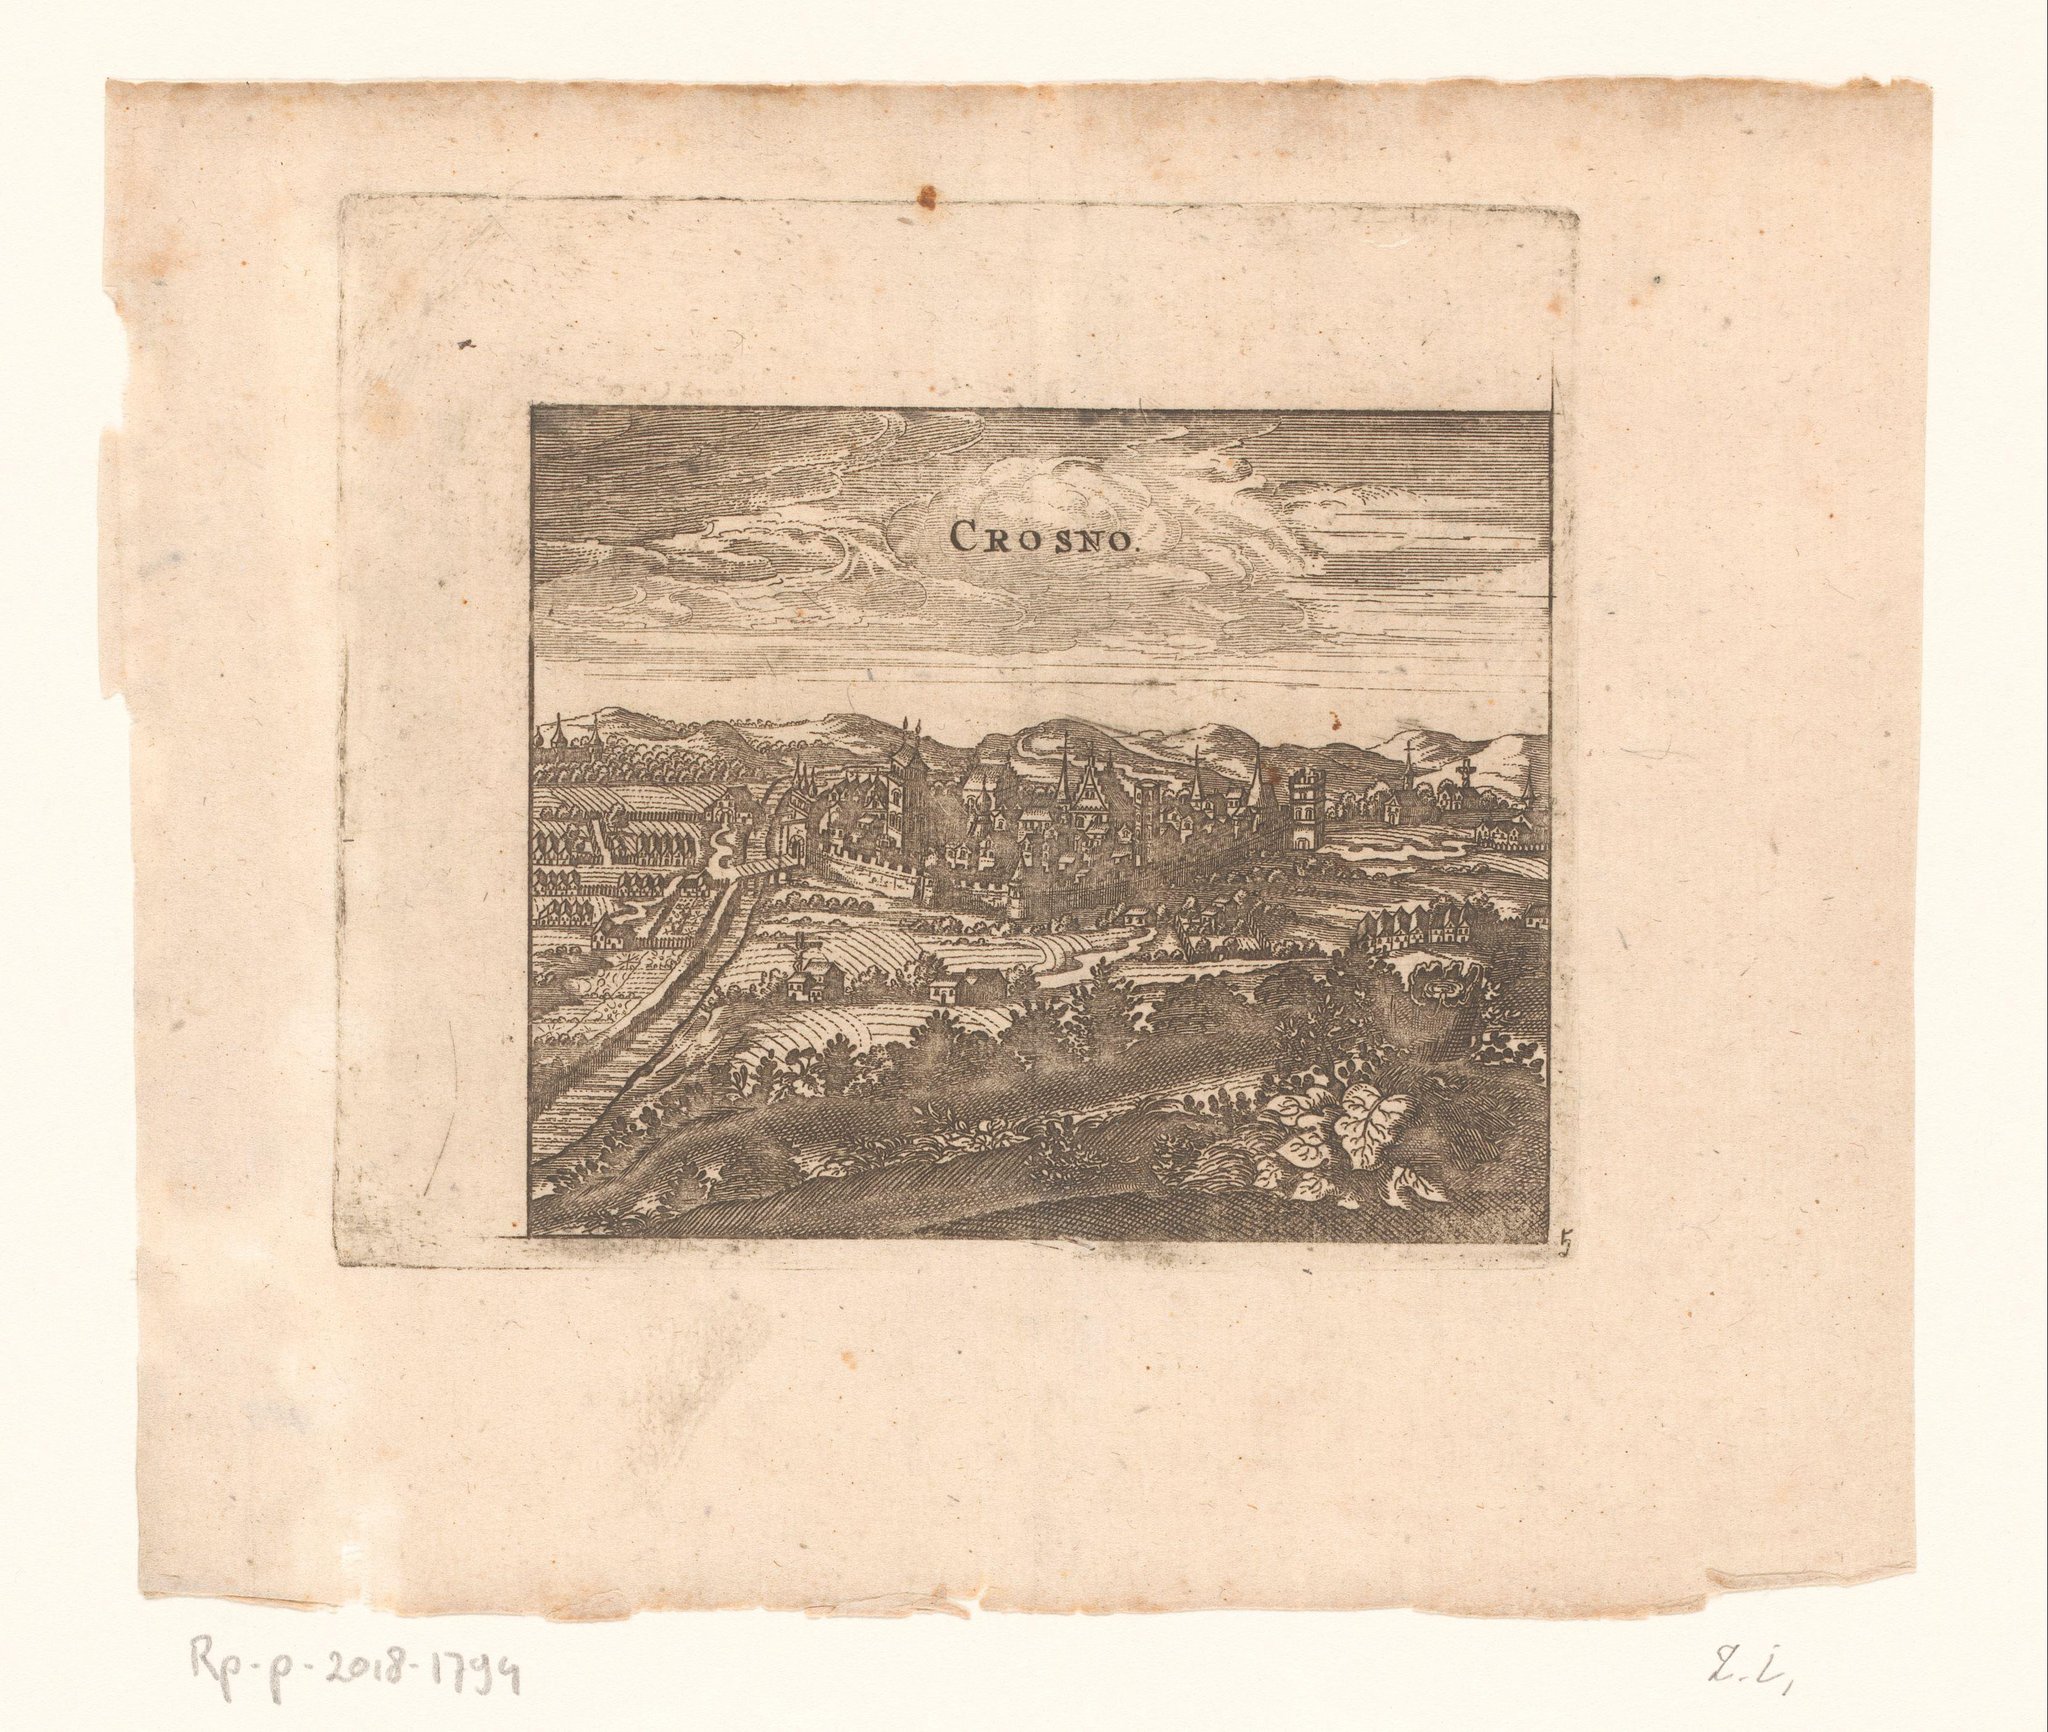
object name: print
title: Gezicht op Krosno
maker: Anonymous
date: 1650-1749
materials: paper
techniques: etching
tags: prospect of city, town panorama, silhouette of city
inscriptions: collector's mark: Lugt 2228